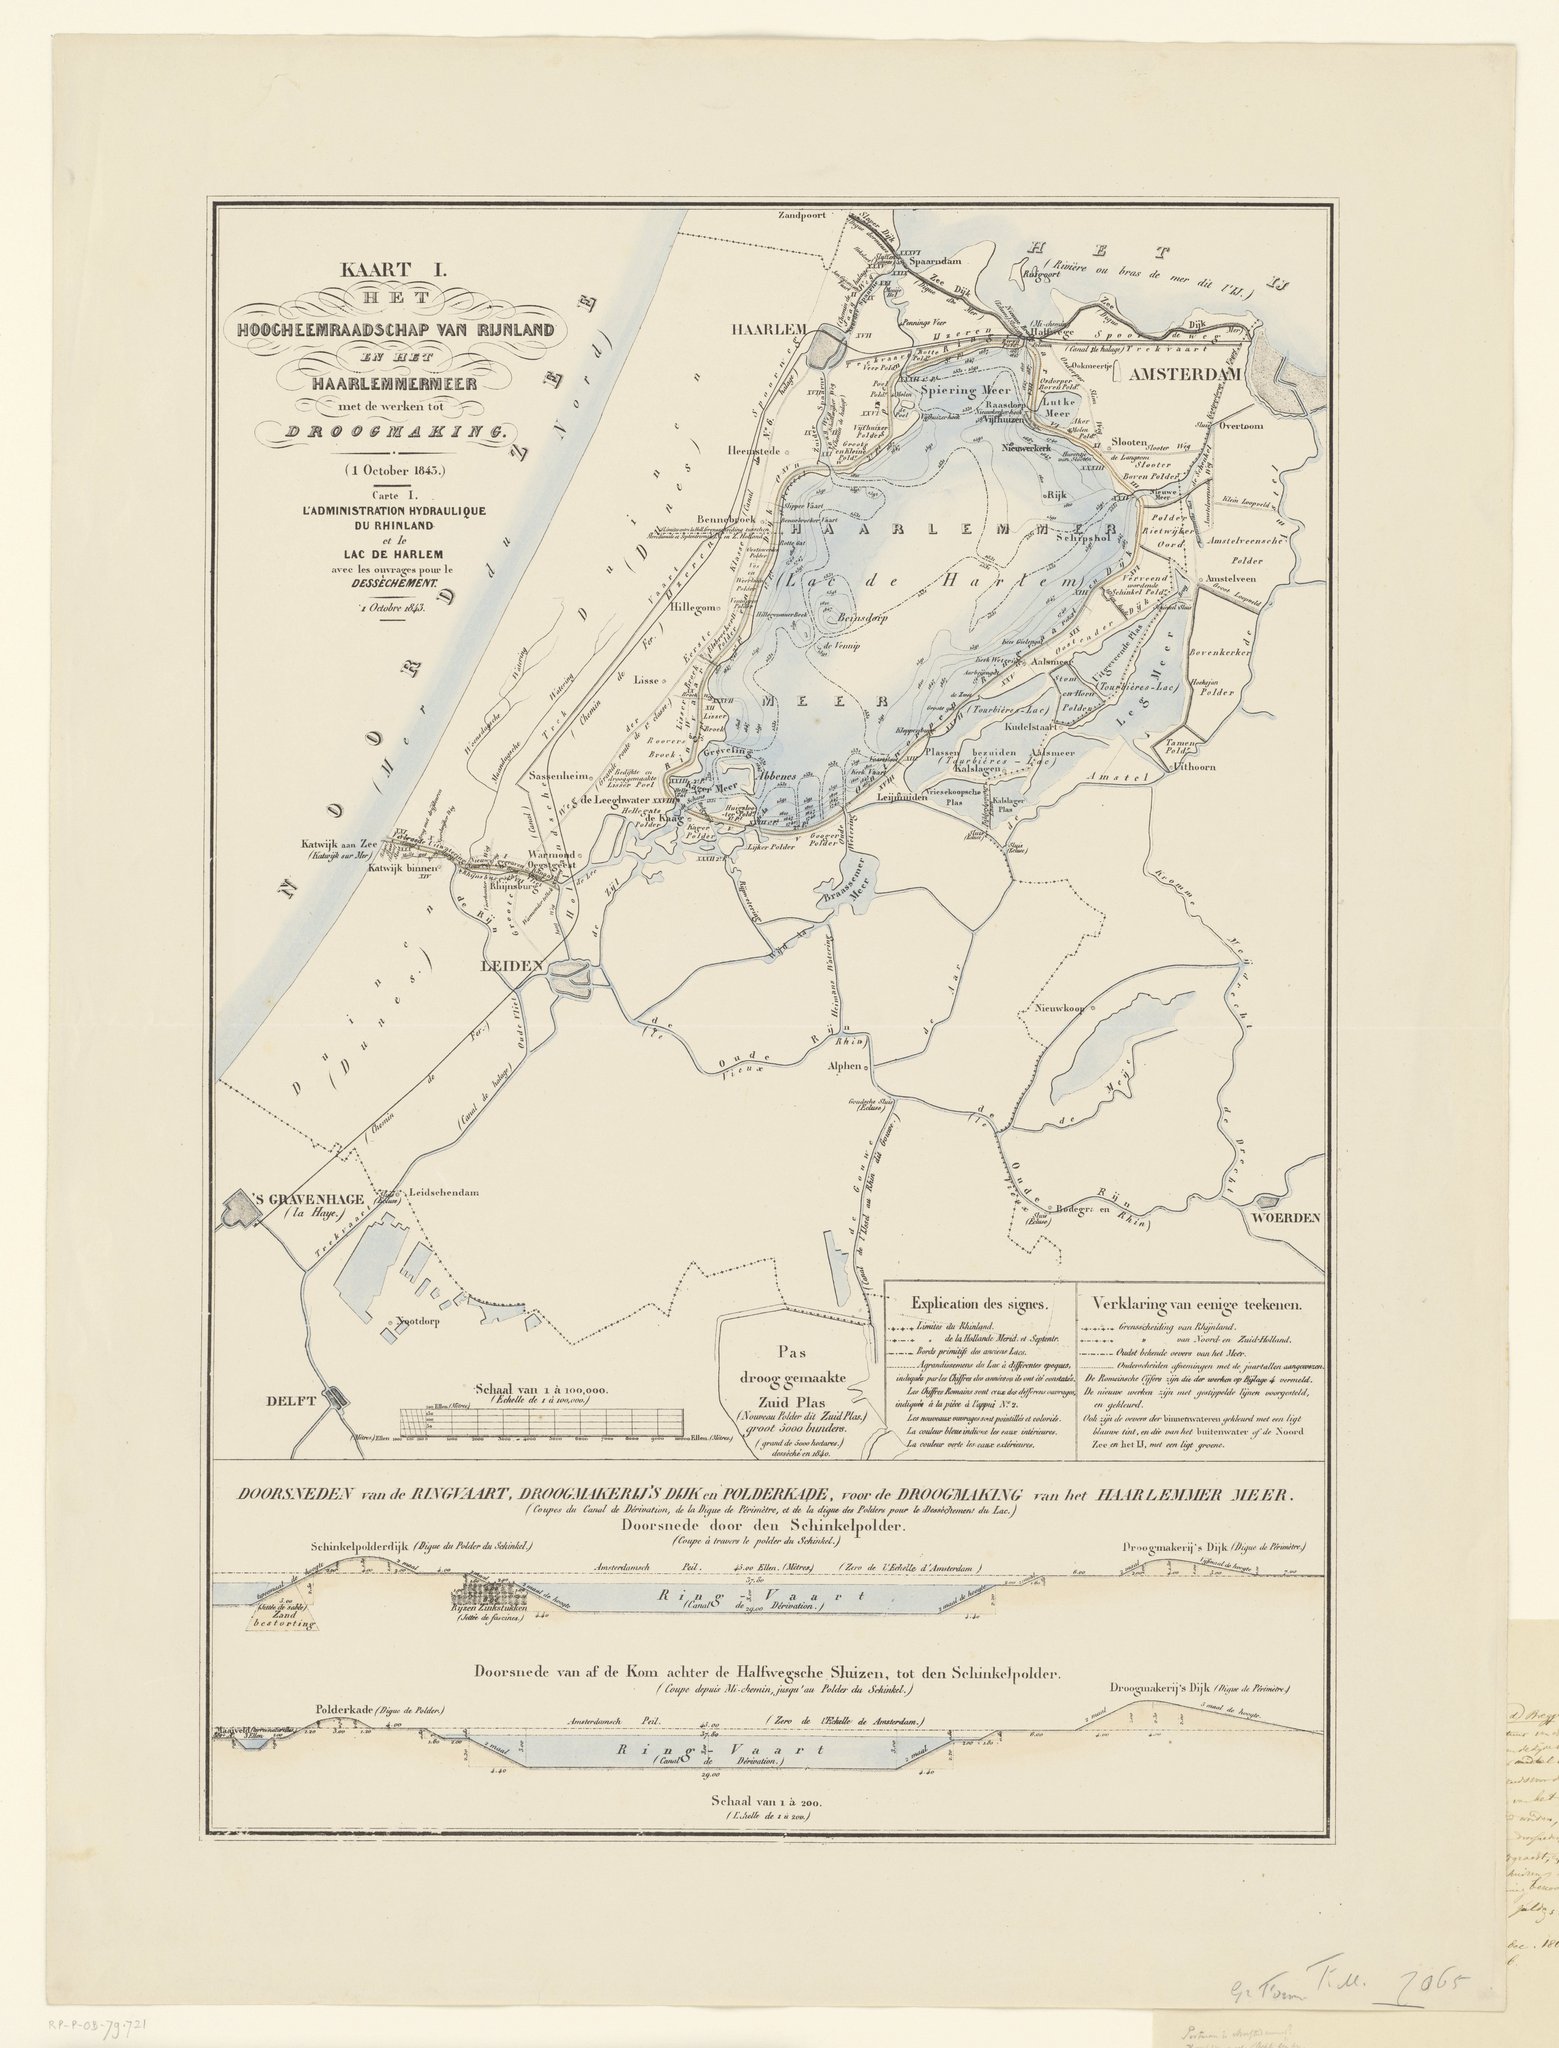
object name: map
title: Kaart I. Het Hoogheemraadschap van Rijnland en het Haarlemmermeer met de werken tot Droogmaking (1 October 1843.)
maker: Anonymous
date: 1843-1861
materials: paper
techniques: hand coloring, lithograph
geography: netherlands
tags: maps of separate countries or regions, polder, reclaimed land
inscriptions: collector's mark: Lugt 2228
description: Kaart van het Hoogheemraadschap van Rijnland en het Haarlemmermeer, met de plannen voor de droogmaking op 1 oktober 1843. Onderaan twee doorsneden van de Ringvaart, ringdijk en polderdijk. Opschriften in het Nederlands en Frans. Onderdeel van een suite van tien platen van de droogmaking van de Haarlemmermeer, 1843-1860.